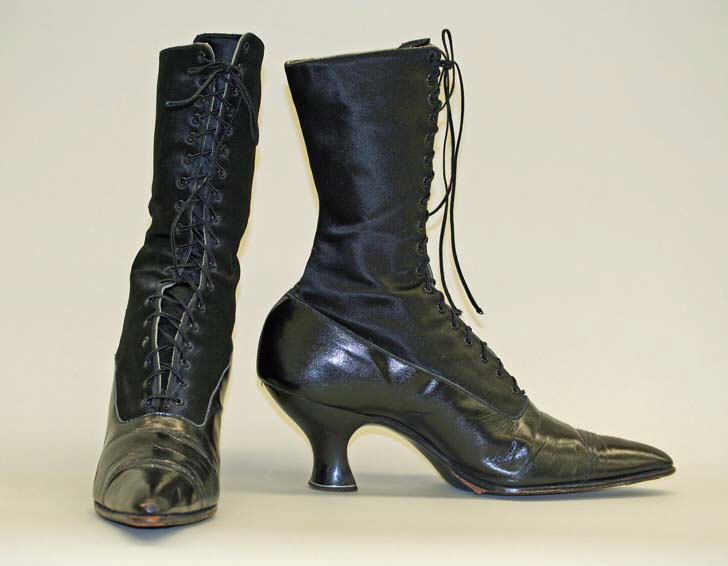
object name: shoe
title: Shoes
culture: american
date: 1910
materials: leather